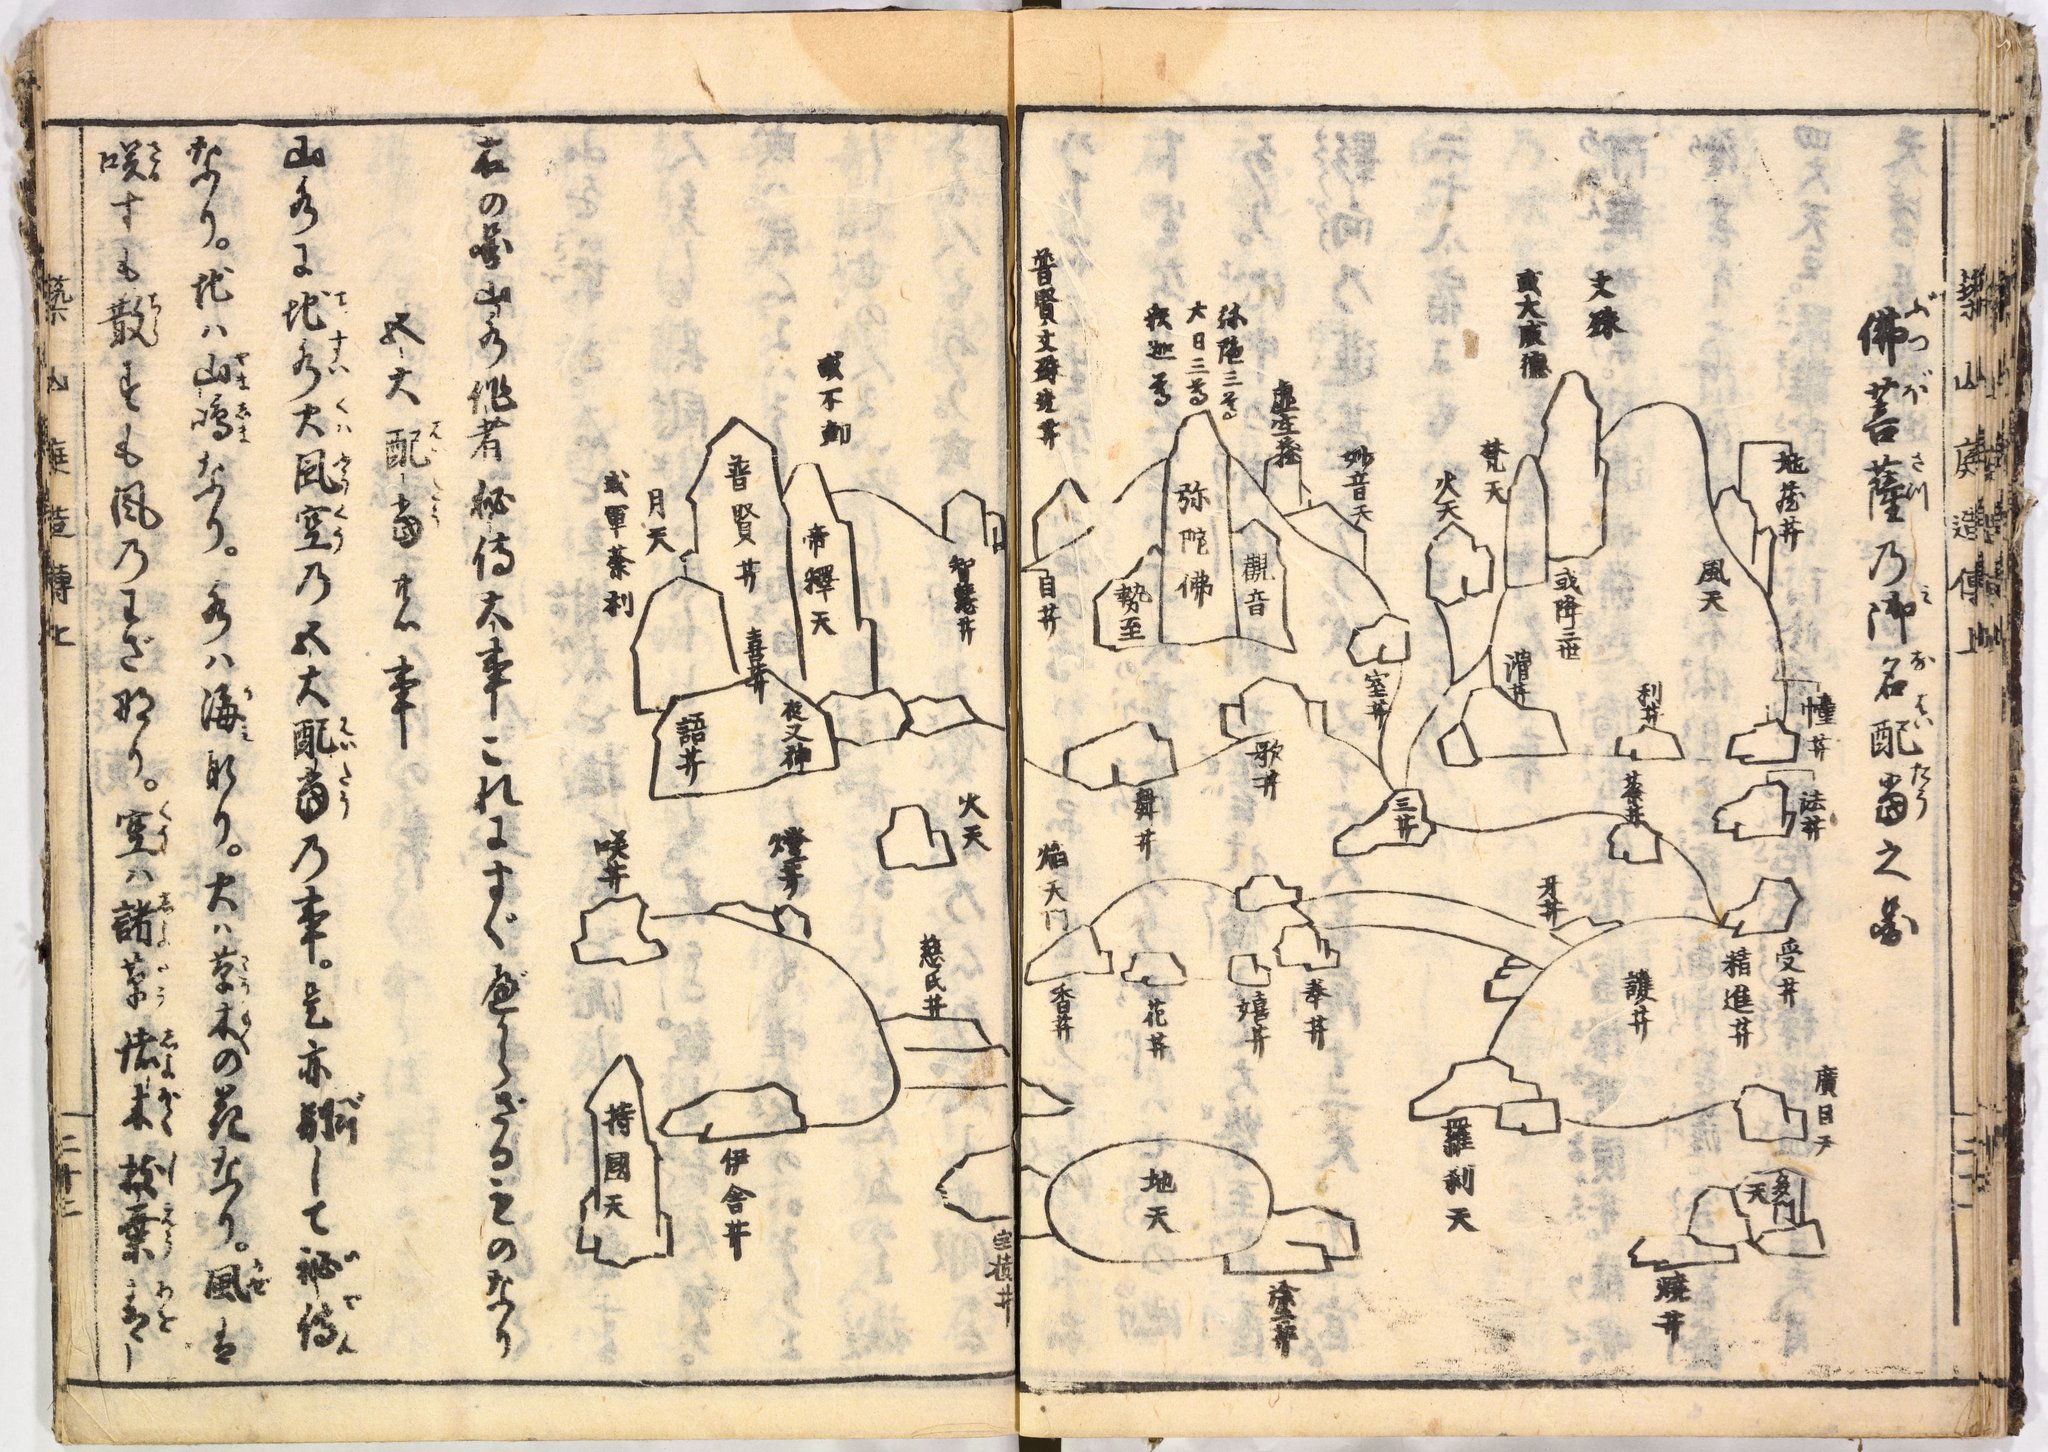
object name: illustrated book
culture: japanese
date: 1893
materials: ink, paper